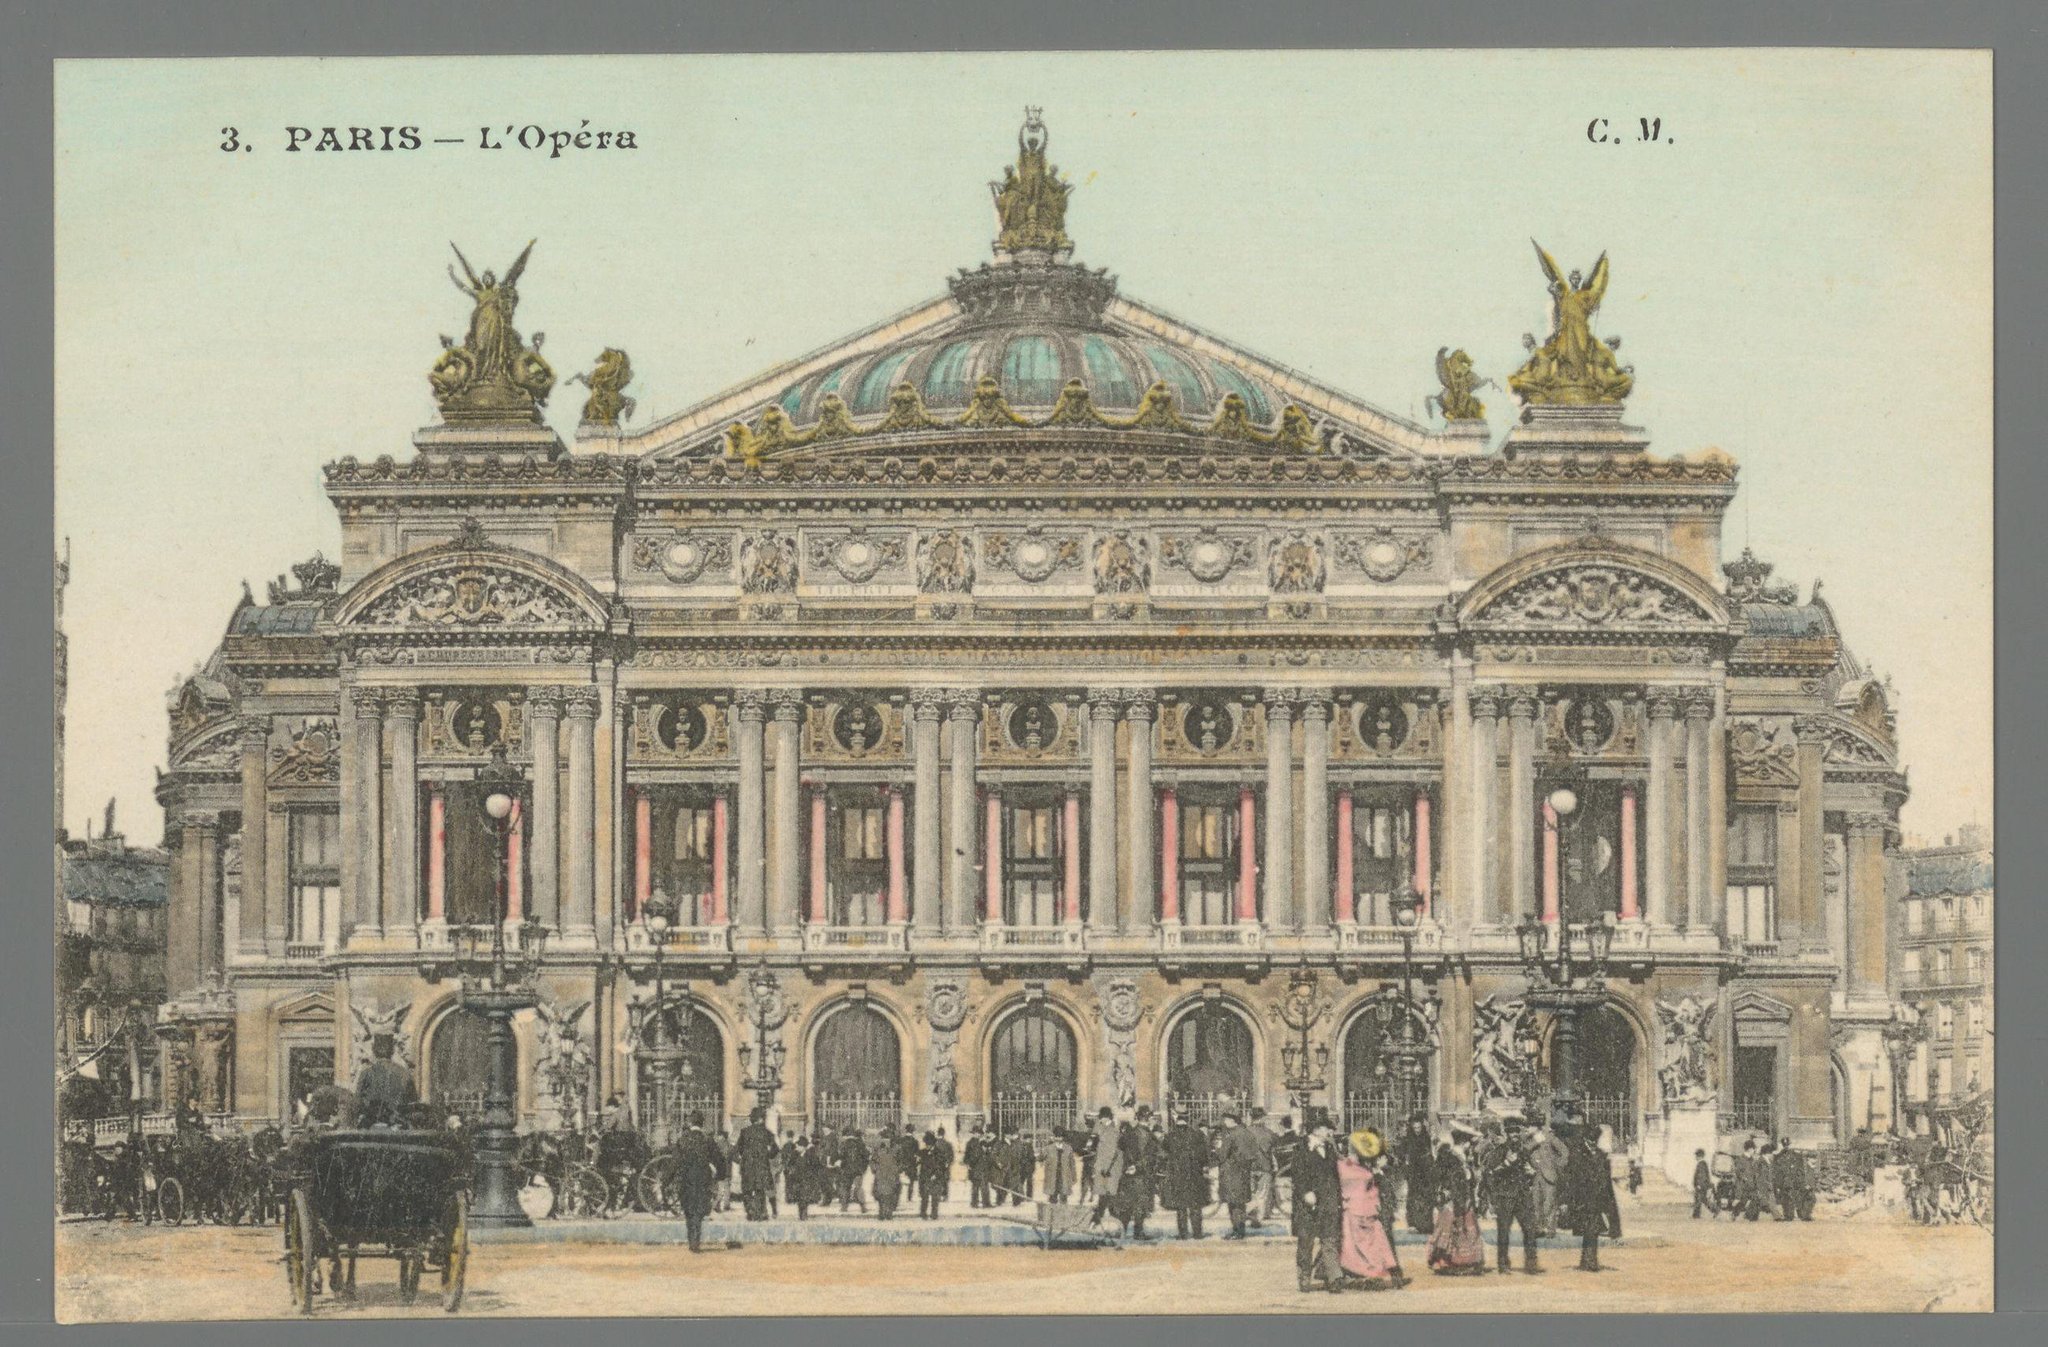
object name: ansichtkaart, prentbriefkaart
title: Paris. L'Opéra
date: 1904-1906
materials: cardboard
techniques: photograph, hand coloring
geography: paris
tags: square, place, circus, etc. (+ city(-scape) with figures, staffage), opera house